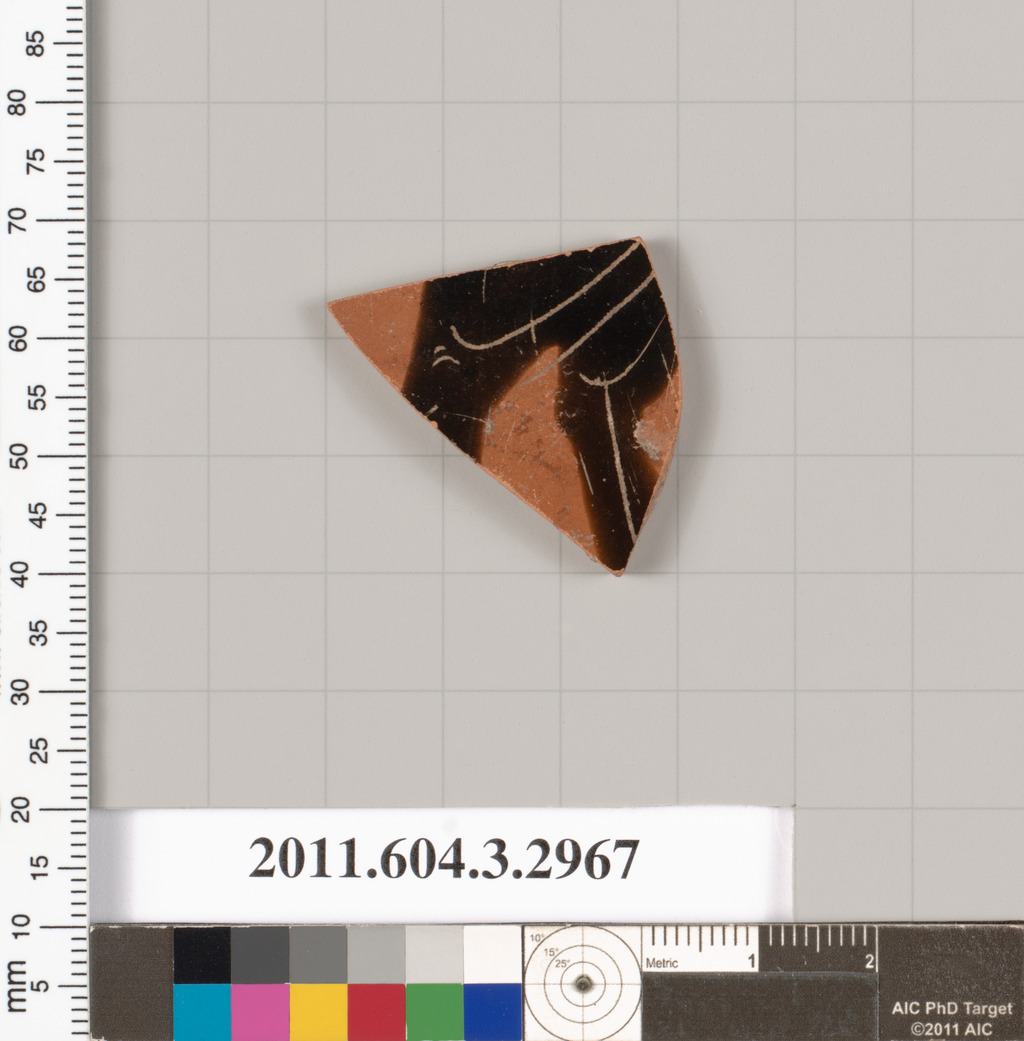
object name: undetermined closed shape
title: Terracotta fragment of a closed shape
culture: greek, attic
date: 534-468 BCE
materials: terracotta